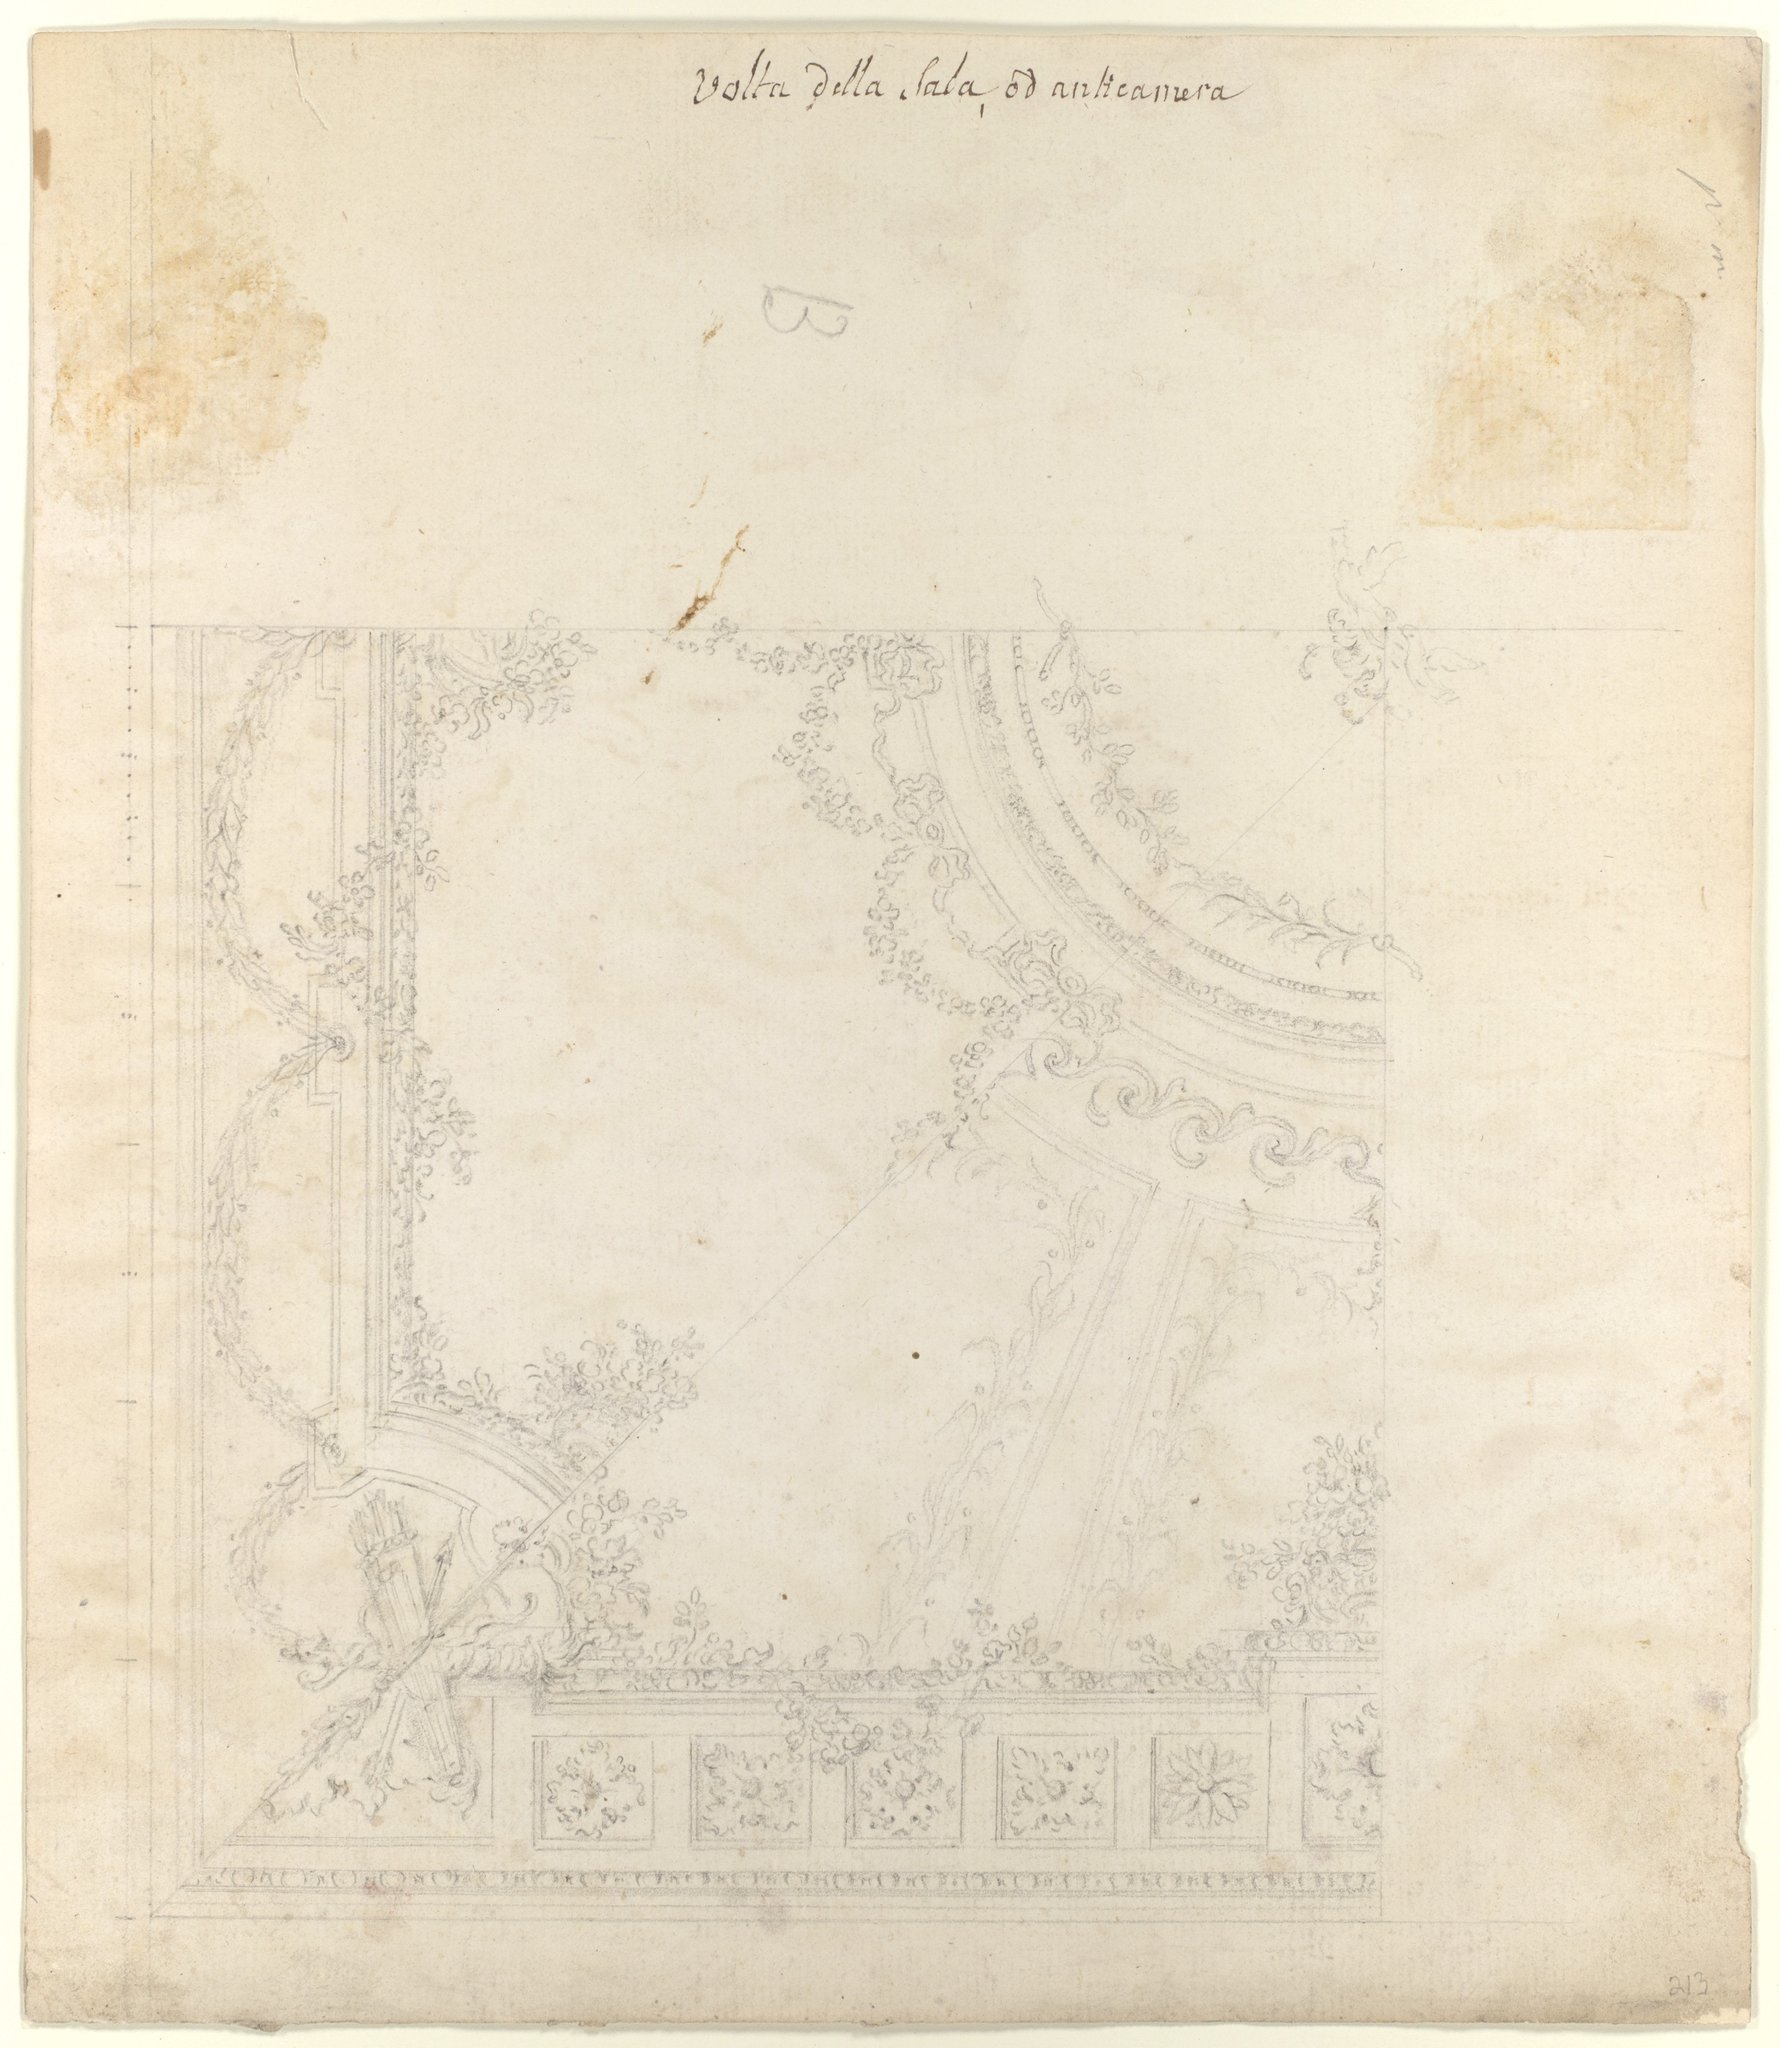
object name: drawing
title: Design for Ceiling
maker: leonardo marini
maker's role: artist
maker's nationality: italian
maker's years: 1730-1797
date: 1701-1800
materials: graphite, drawing material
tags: ceilings